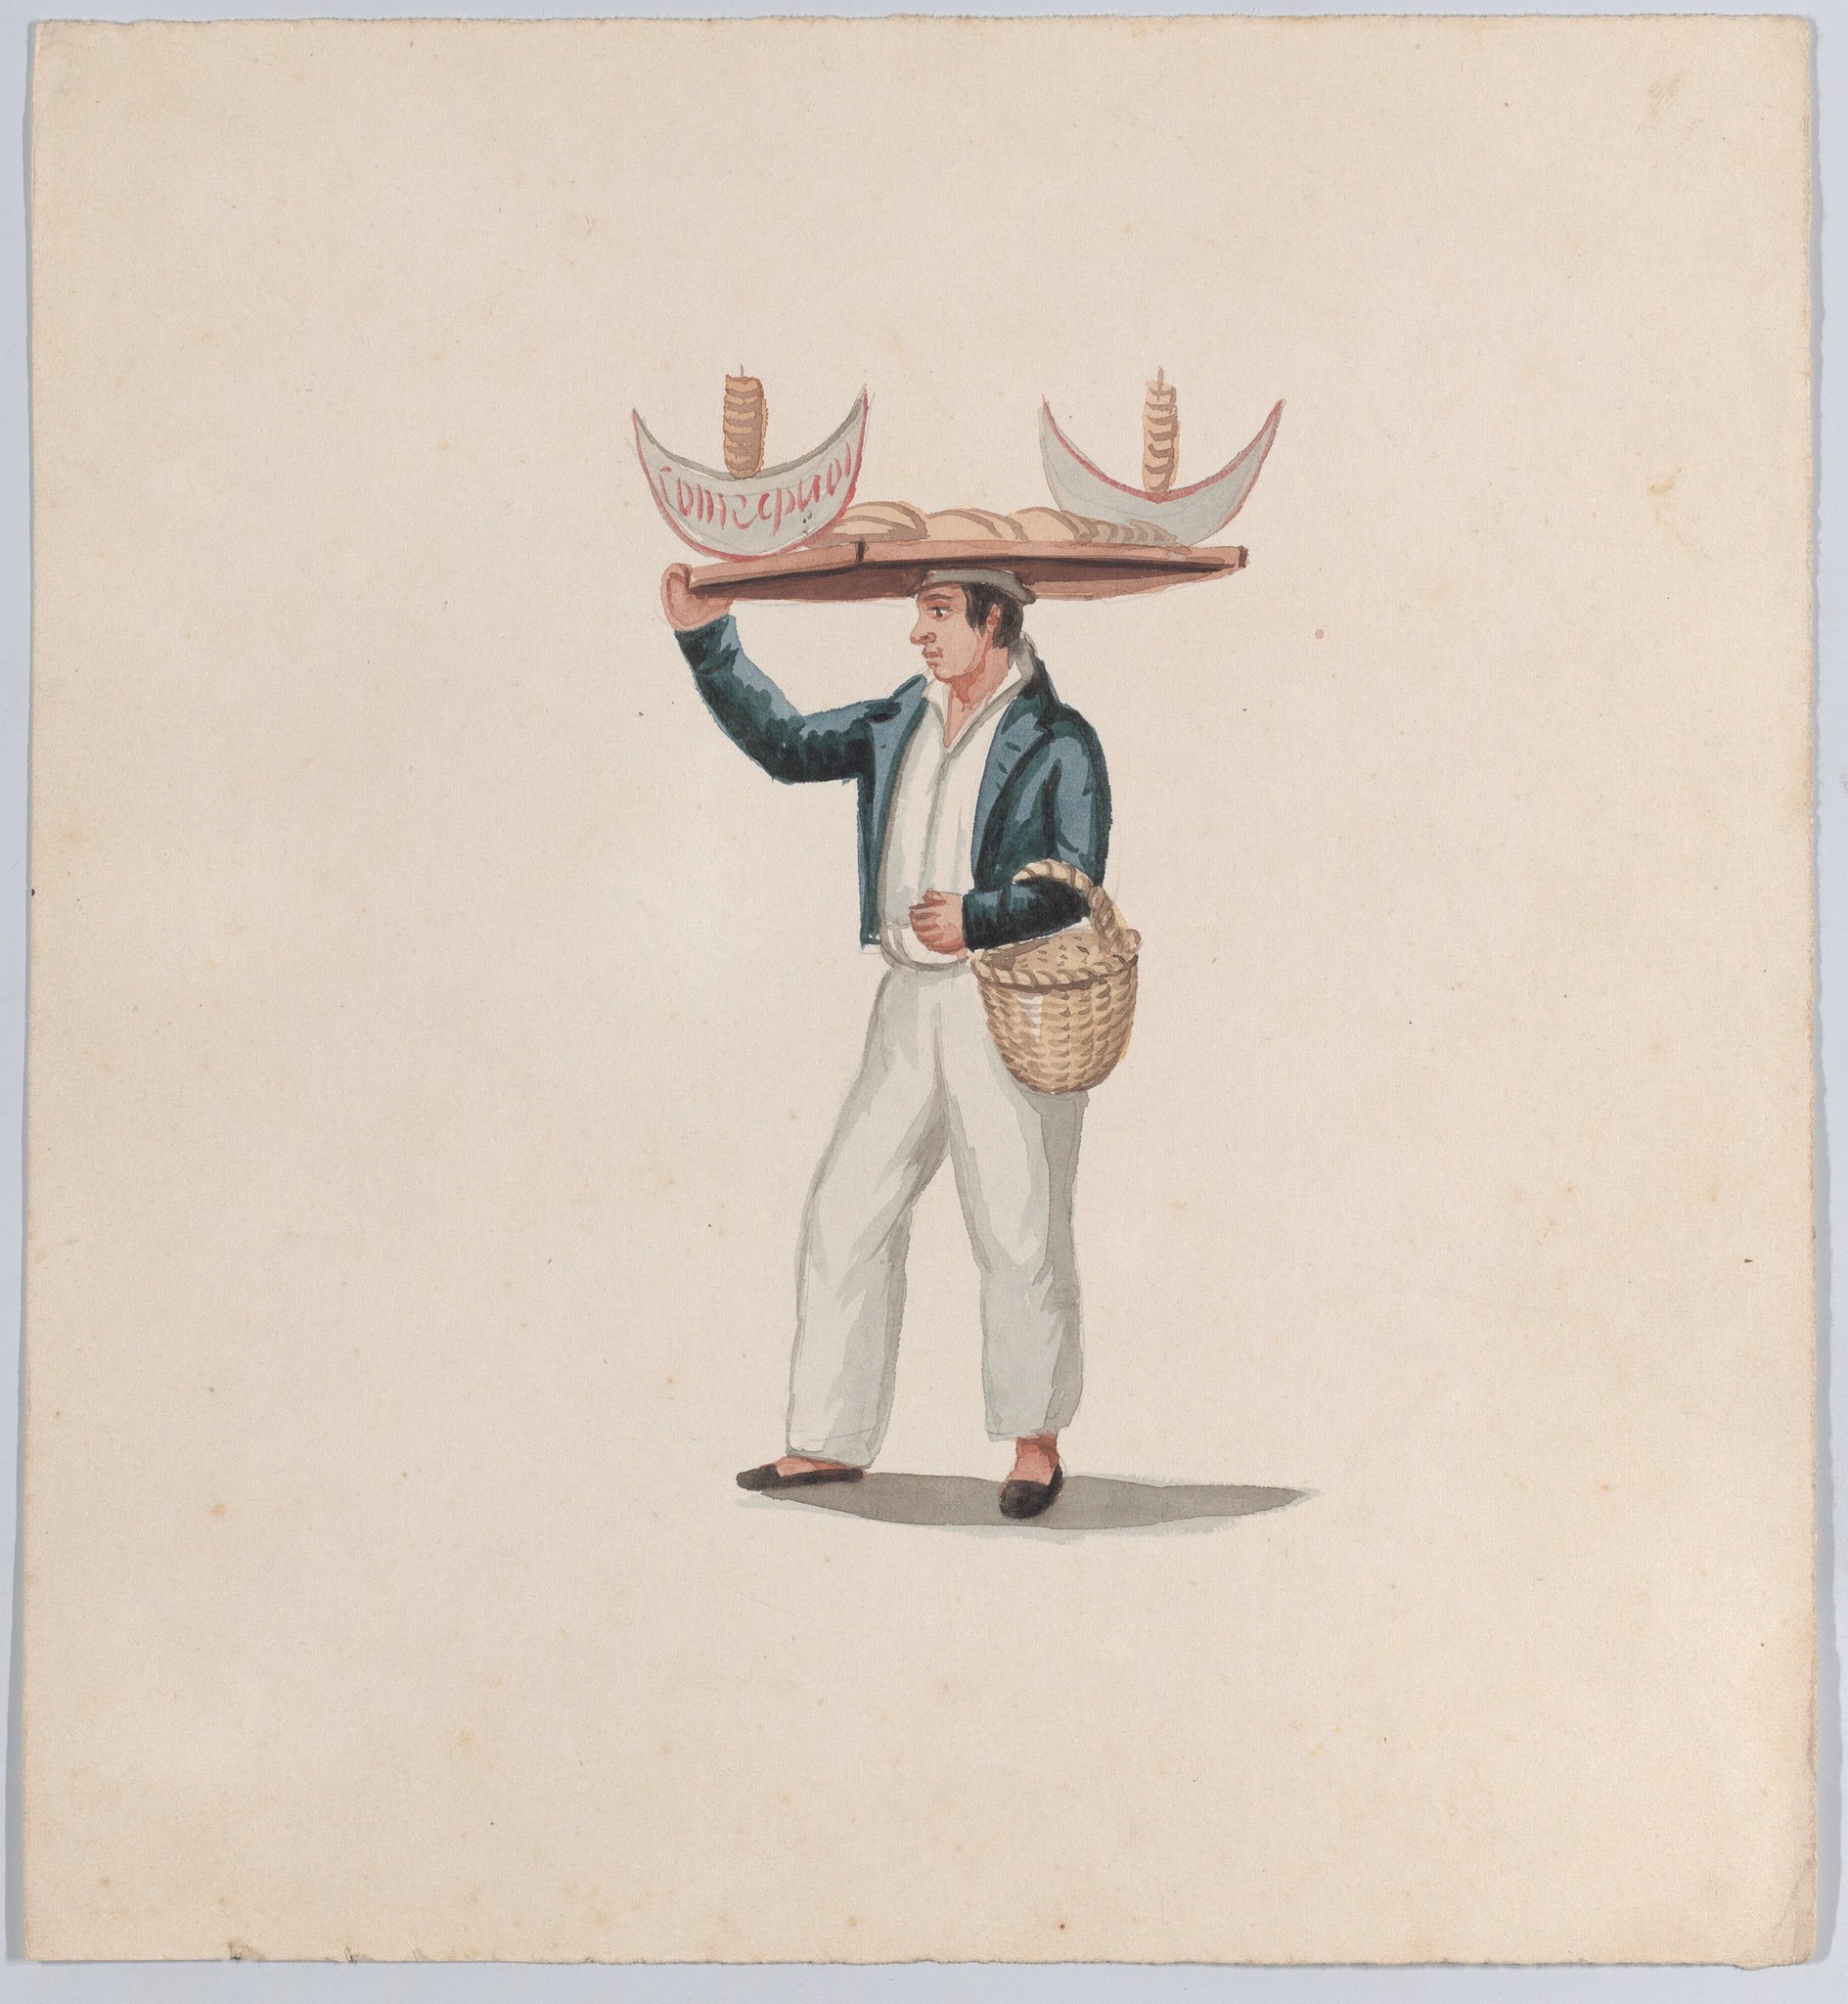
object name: drawing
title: A tortilla vendor balancing a tray on his head, from a group of drawings depicting Peruvian dress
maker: francisco (pancho) fierro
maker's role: artist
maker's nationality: african peruvian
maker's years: 1807-1879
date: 1848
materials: watercolor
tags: men,women